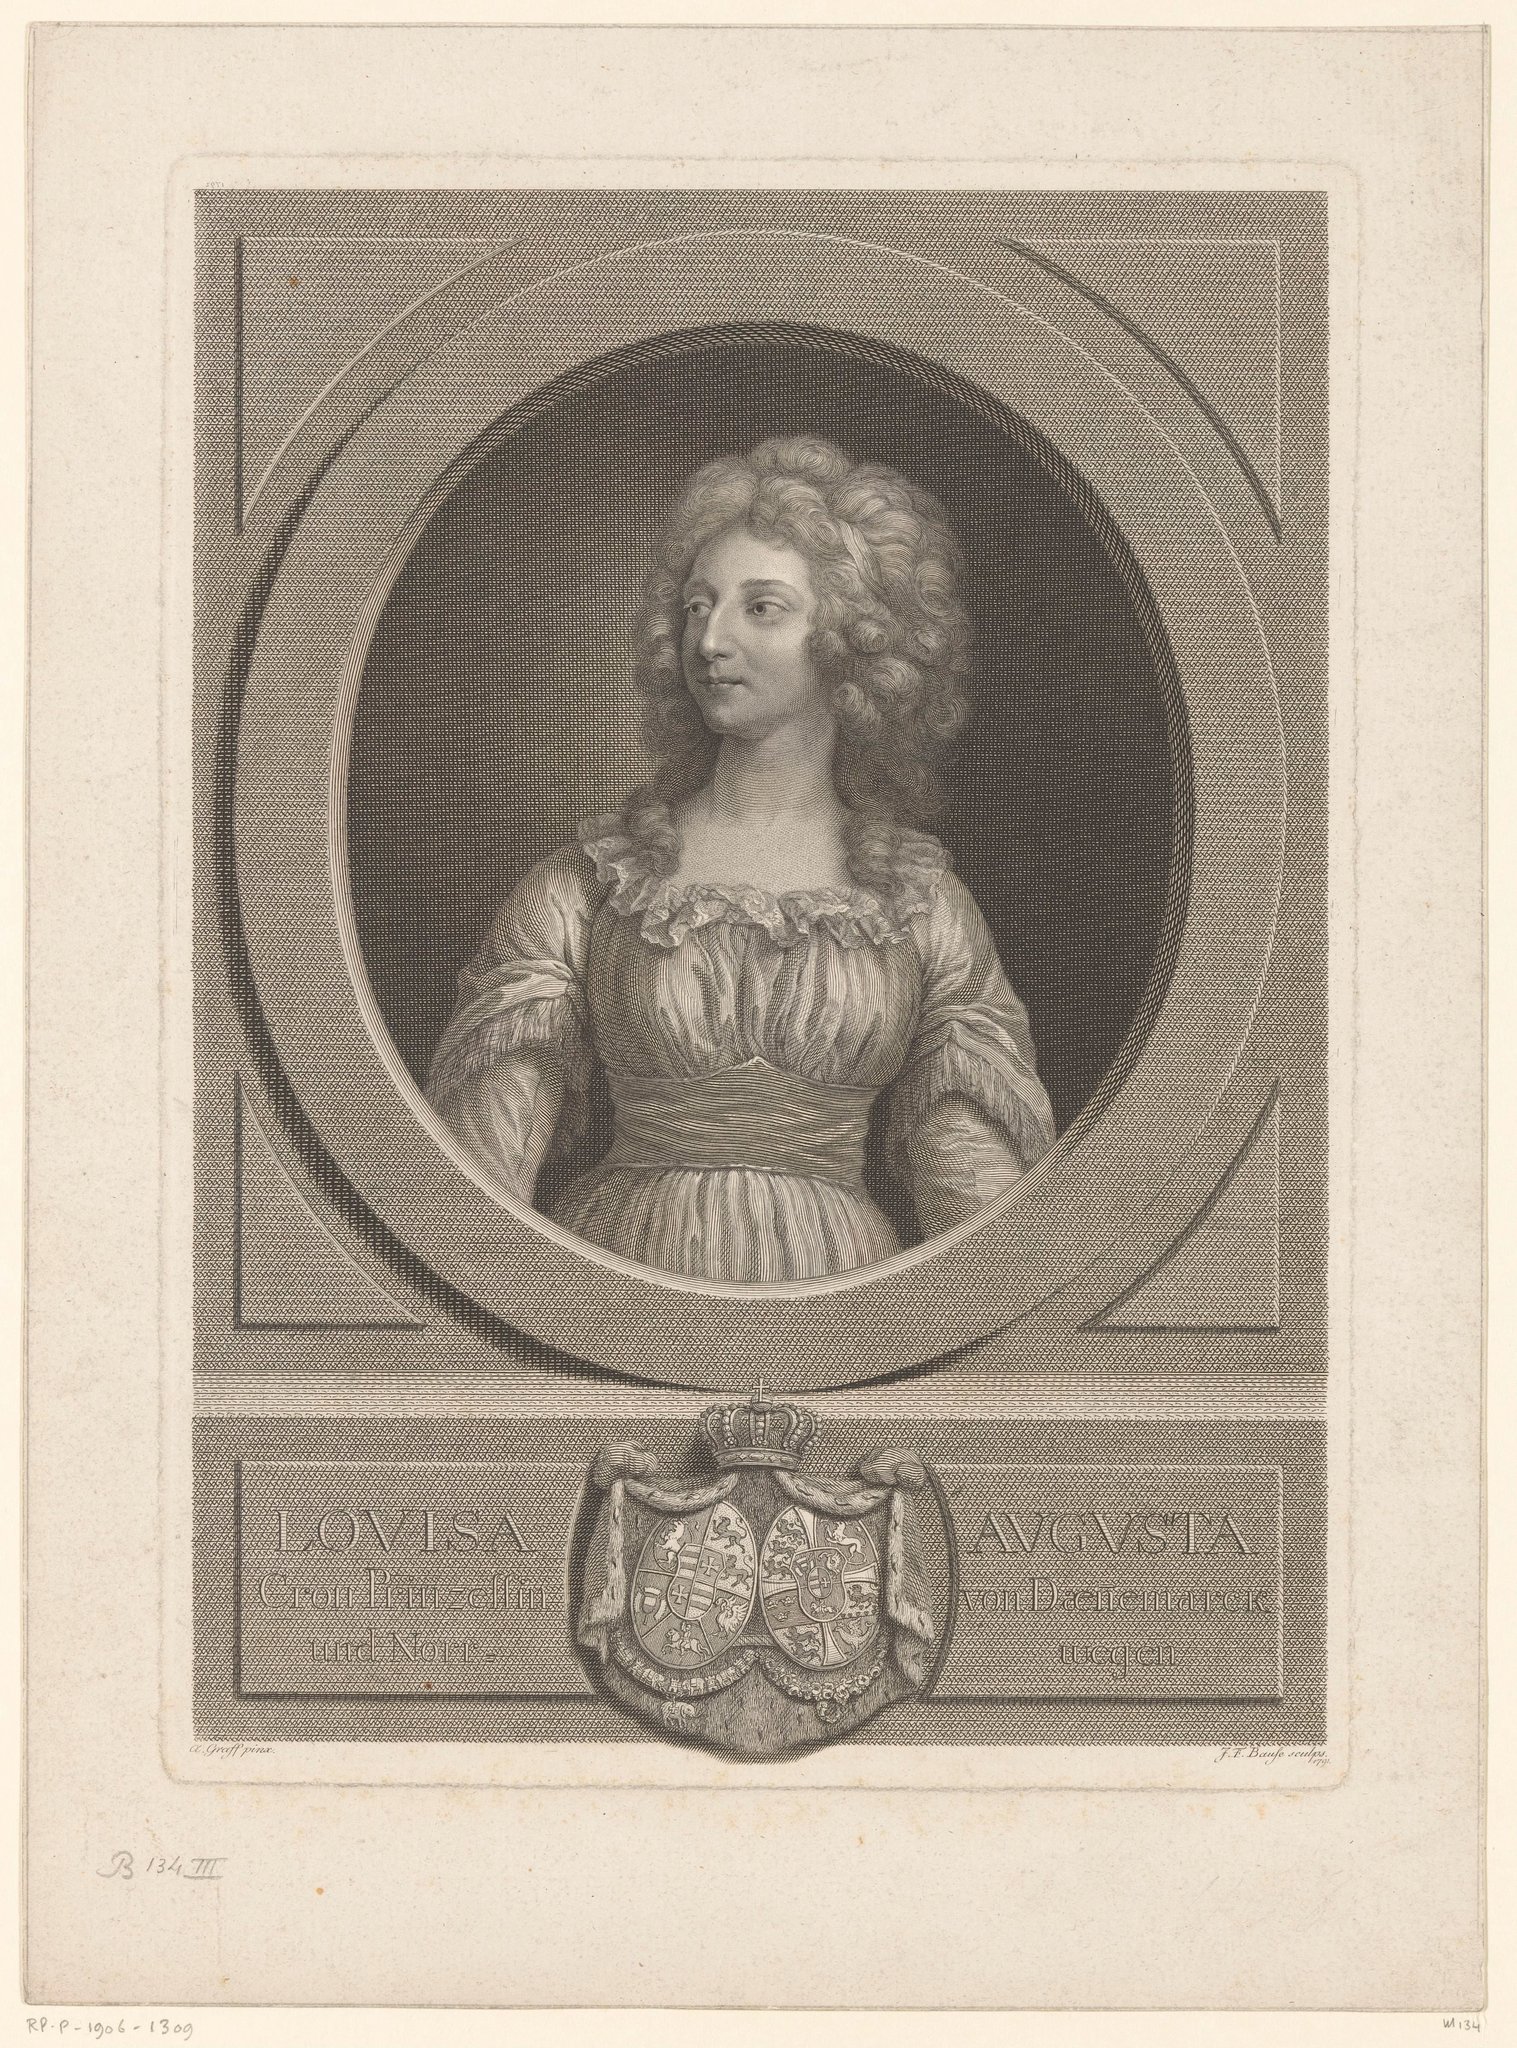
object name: print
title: Louisa Augusta, kroonprinses van Denemarken en Noorwegen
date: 1791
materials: paper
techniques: engraving, etching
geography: leipzig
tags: historical persons - bb - woman, armorial bearing, heraldry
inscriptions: collector's mark: Lugt 2228